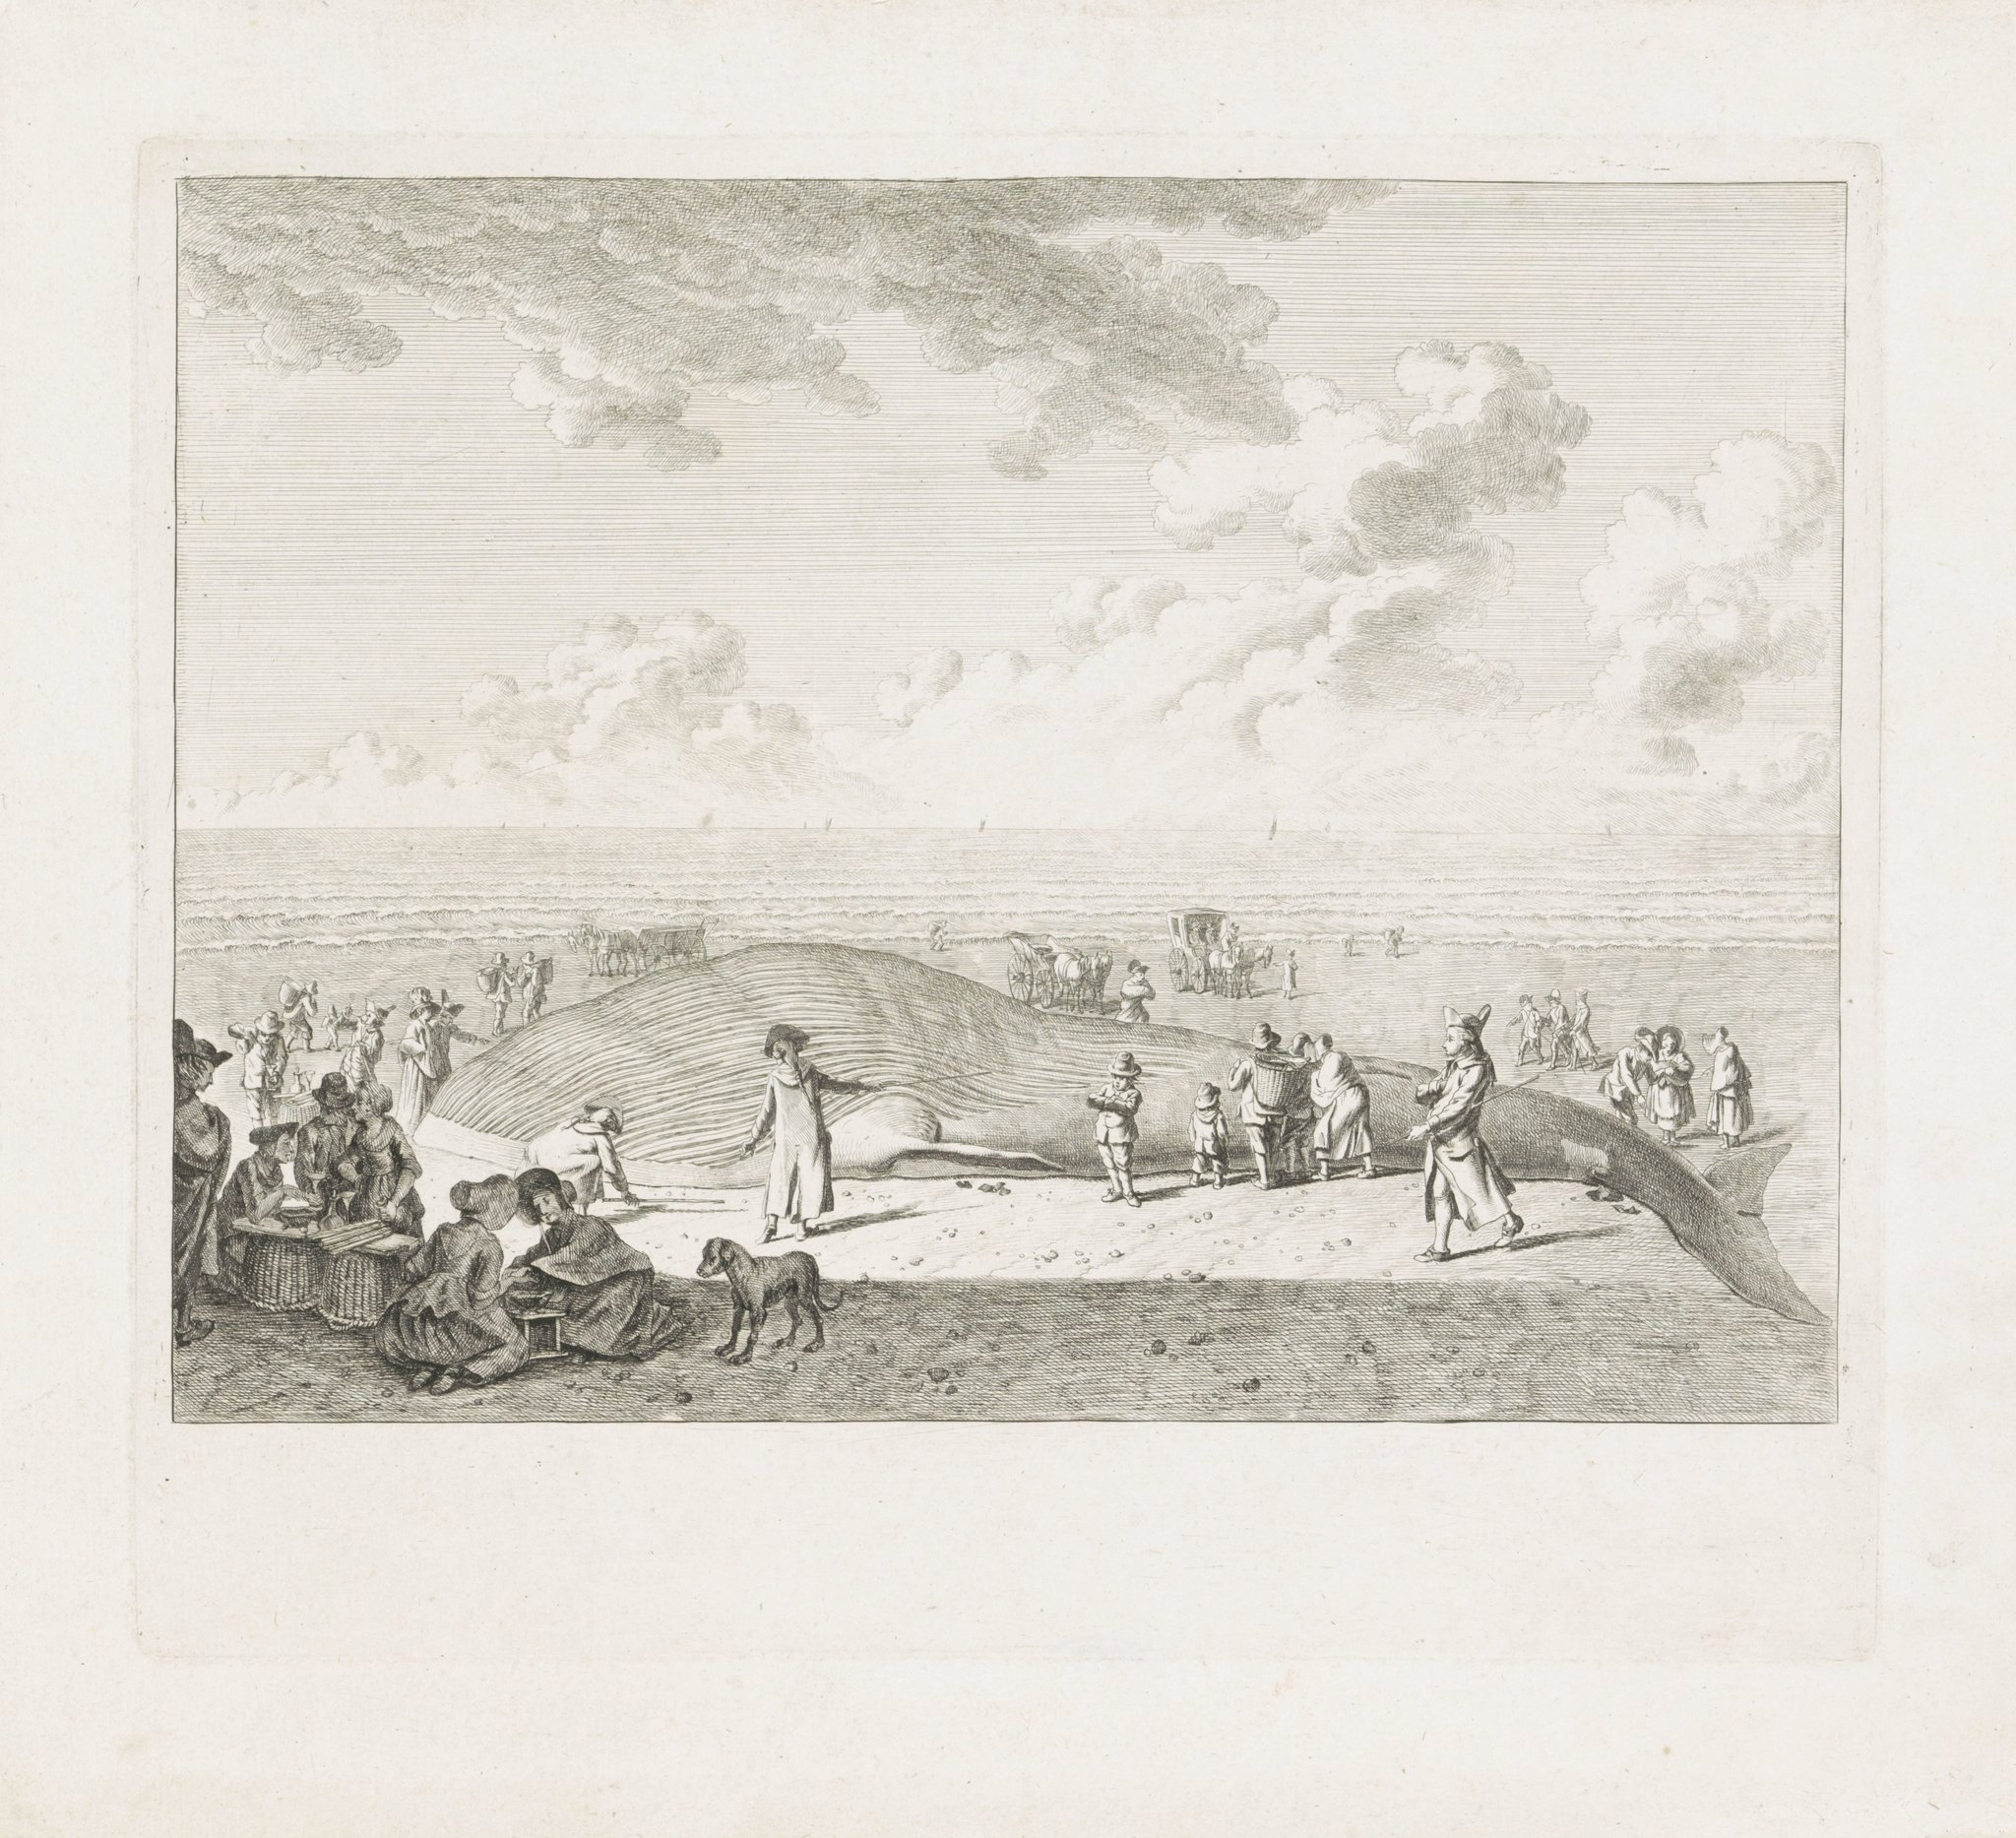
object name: print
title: Vinvis gestrand bij Wijk aan Zee, 1791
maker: leendert overbeek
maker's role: draughtsman, painter, print maker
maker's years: 1752-1815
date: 1792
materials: paper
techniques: engraving, etching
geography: northern netherlands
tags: swimming mammals: whale (+ dying animal; death of animal; dead animal)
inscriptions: collector's mark: Lugt 2228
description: Een gewone vinvis gestrand tussen Wijk aan Zee en Zandvoort op 18 november 1791. Rondom het dier lopen en zitten toeschouwers, op de achtergrond enkele rijtuigen op het strand.